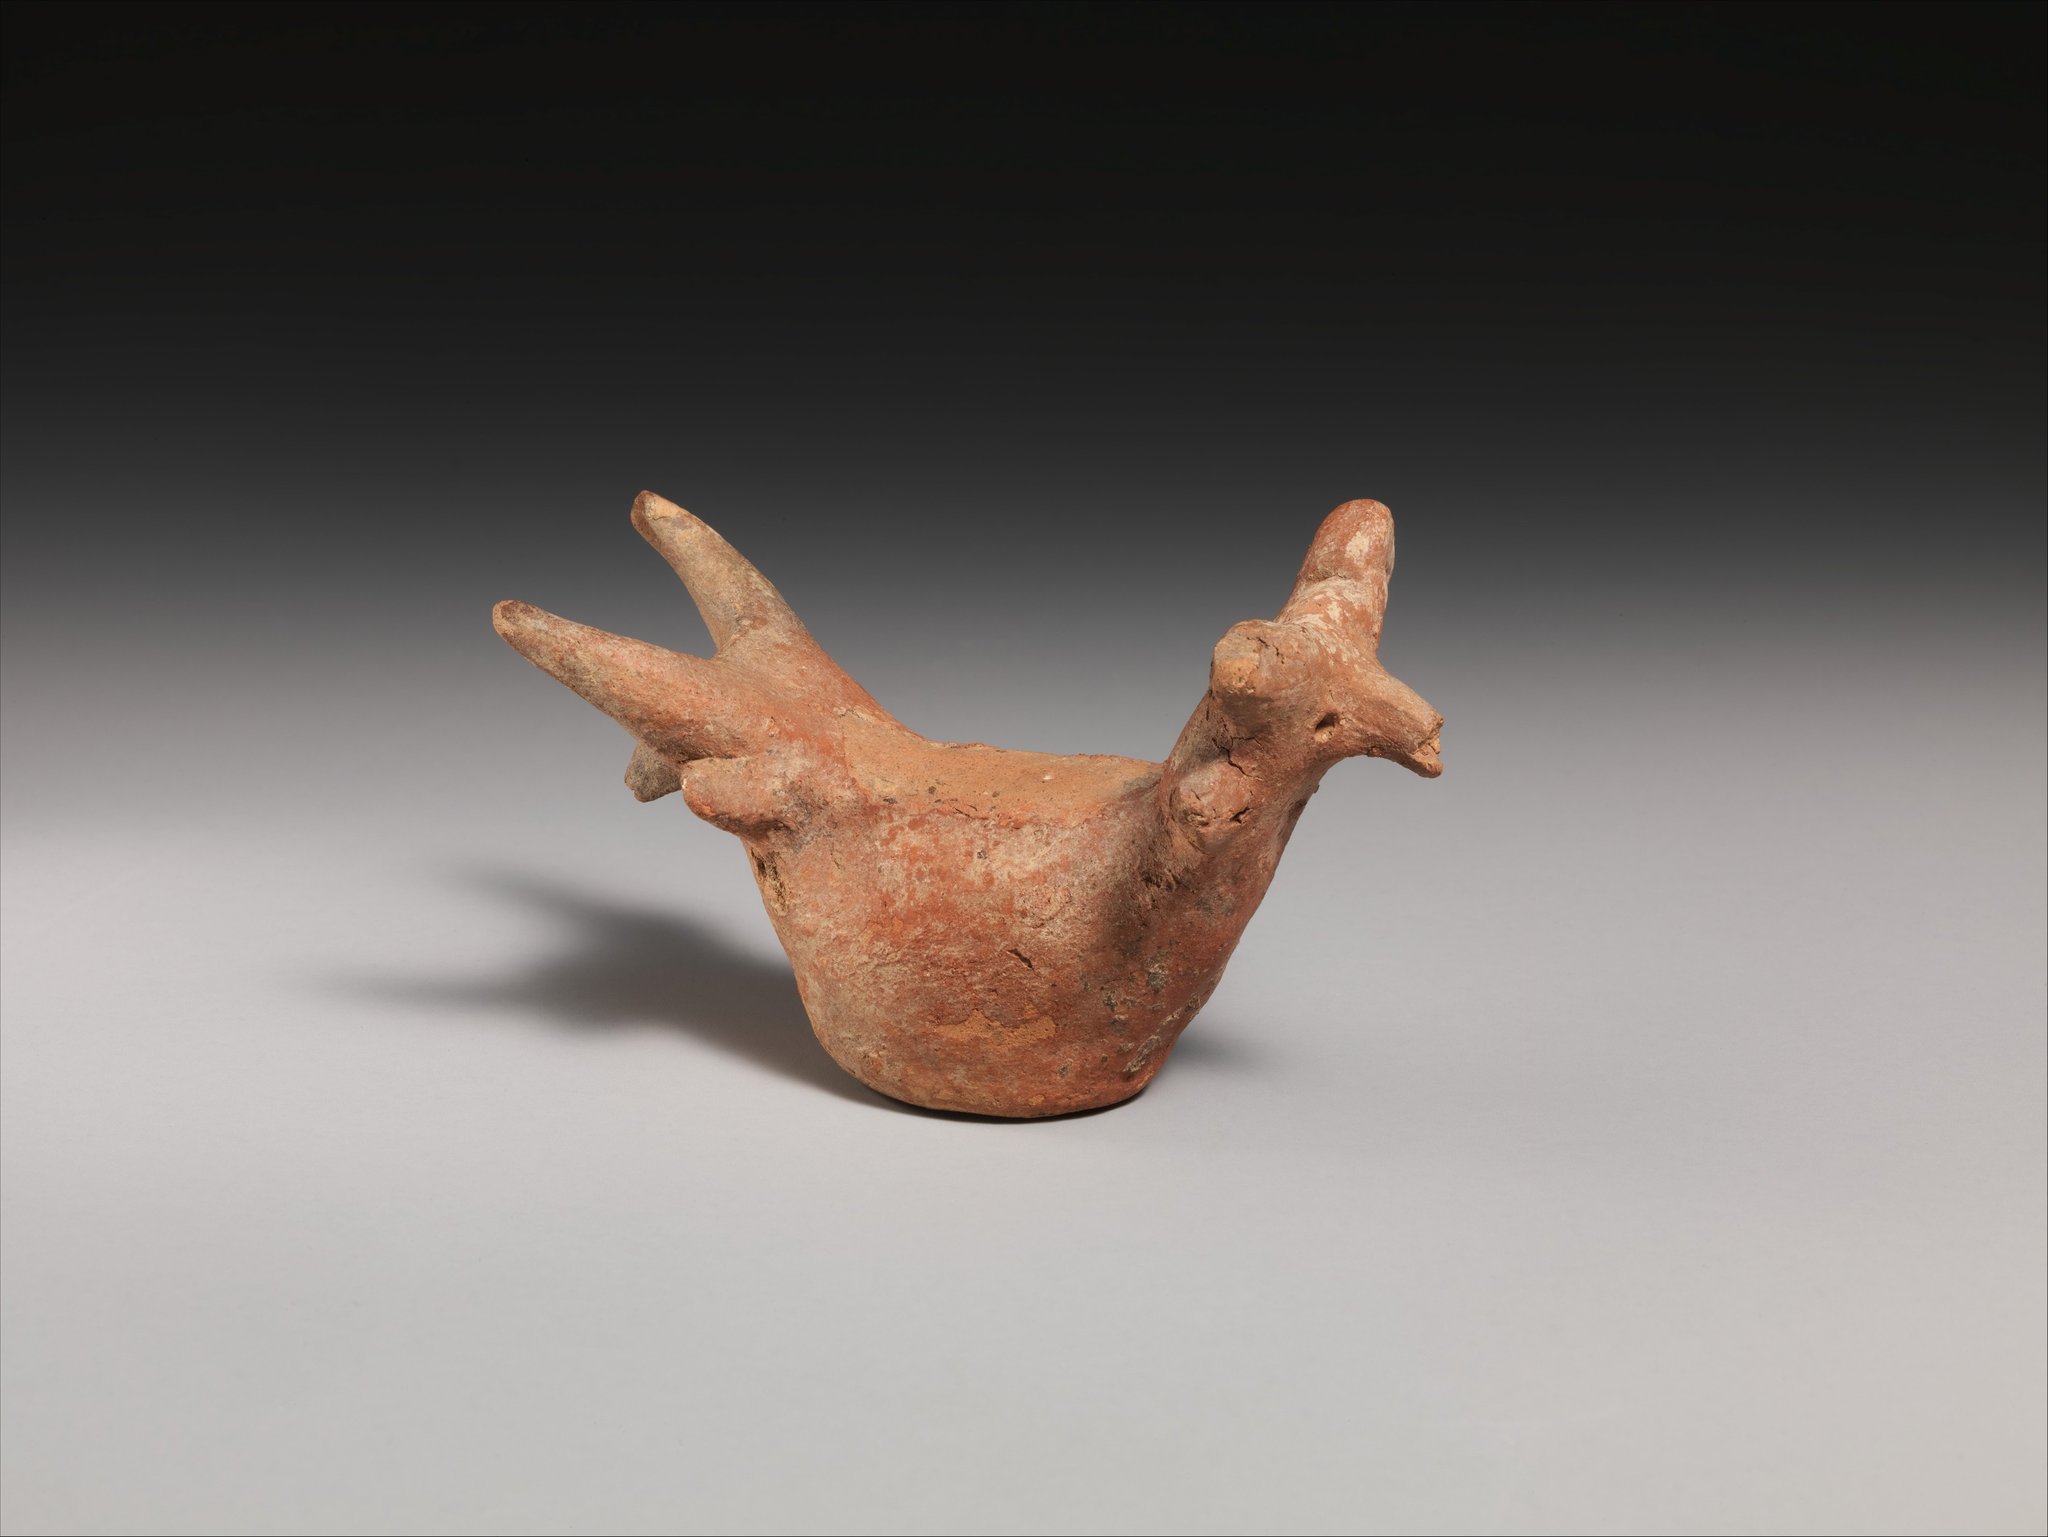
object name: figurine in the form of an askos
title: Terracotta figurine in the form of a zoomorphic askos (vessel)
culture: cypriot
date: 1900-1800 BCE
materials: terracotta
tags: animals